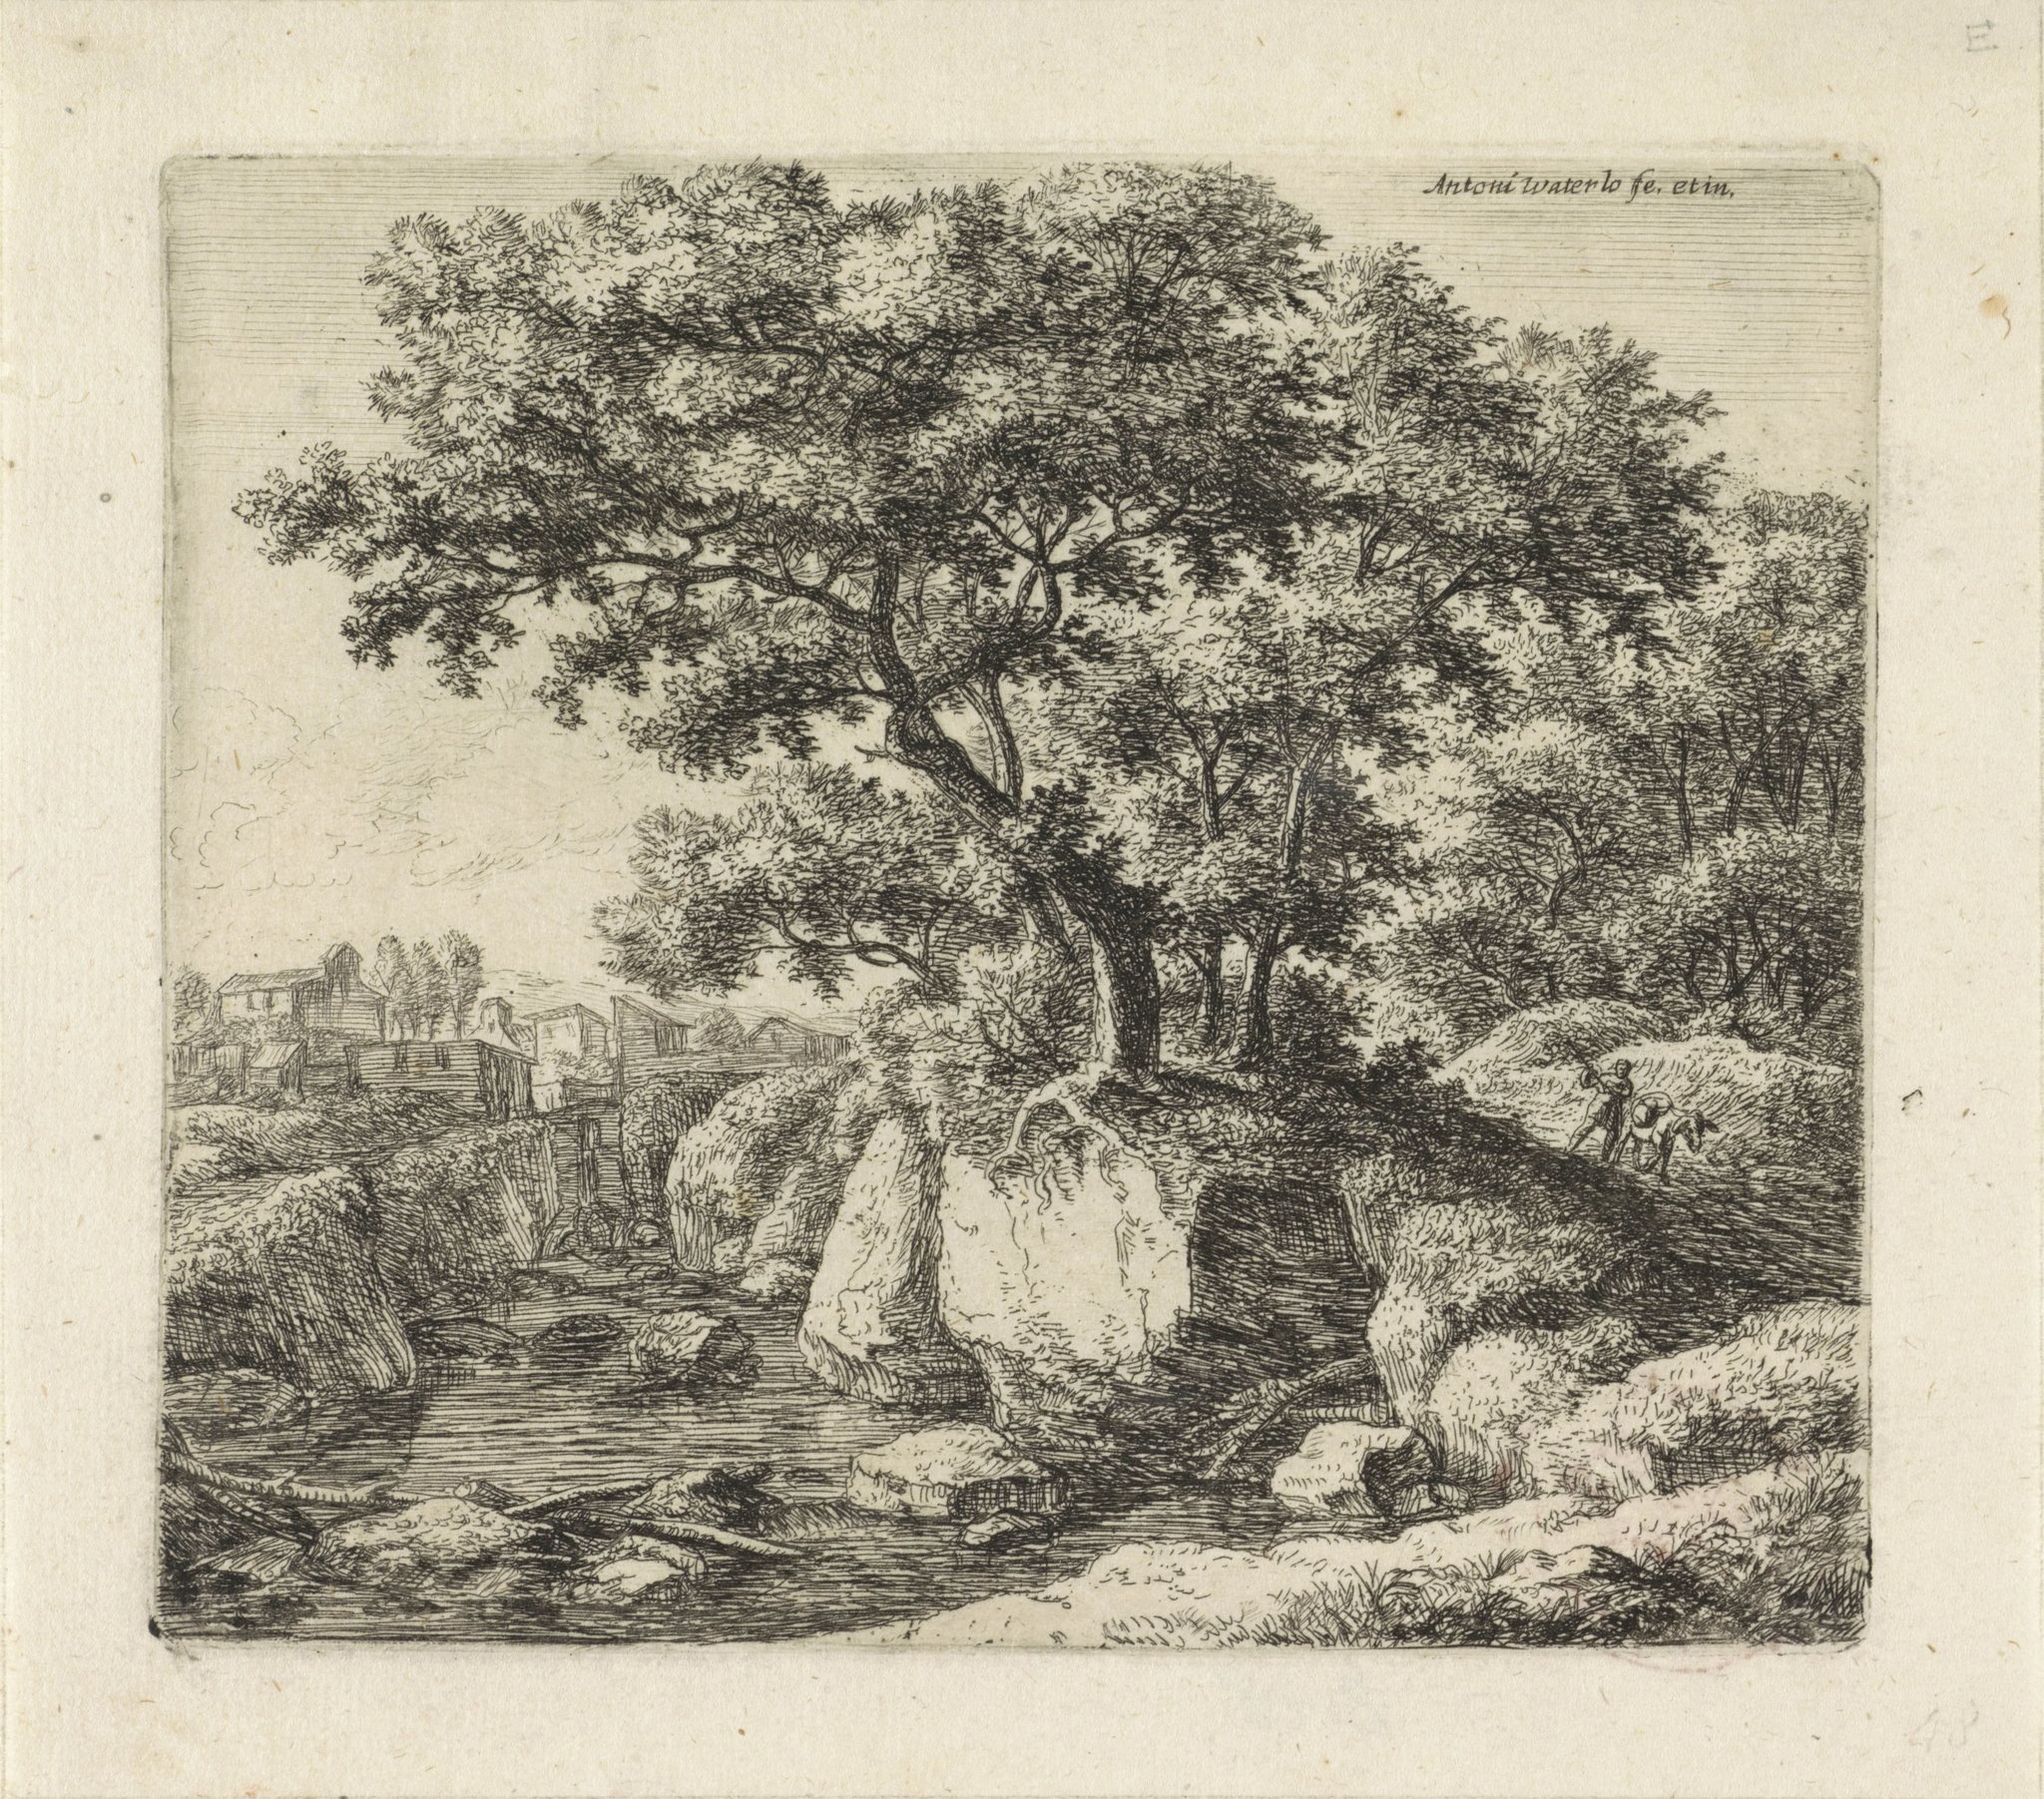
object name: print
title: Heuvellandschappen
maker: anthonie waterloo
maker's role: draughtsman, painter, print maker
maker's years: 1609-1690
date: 1630-1663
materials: paper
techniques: etching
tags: low hill country, mule (+ one person ~ traffic and transport), river, housing, landscapes (+ landscape with figures, staffage)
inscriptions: collector's mark: Lugt 240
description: Een rivier loopt door een heuvelachtig landschap met rotspartijen. Links staan enkele huizen. Rechts drijft een man twee ezels over een pad.